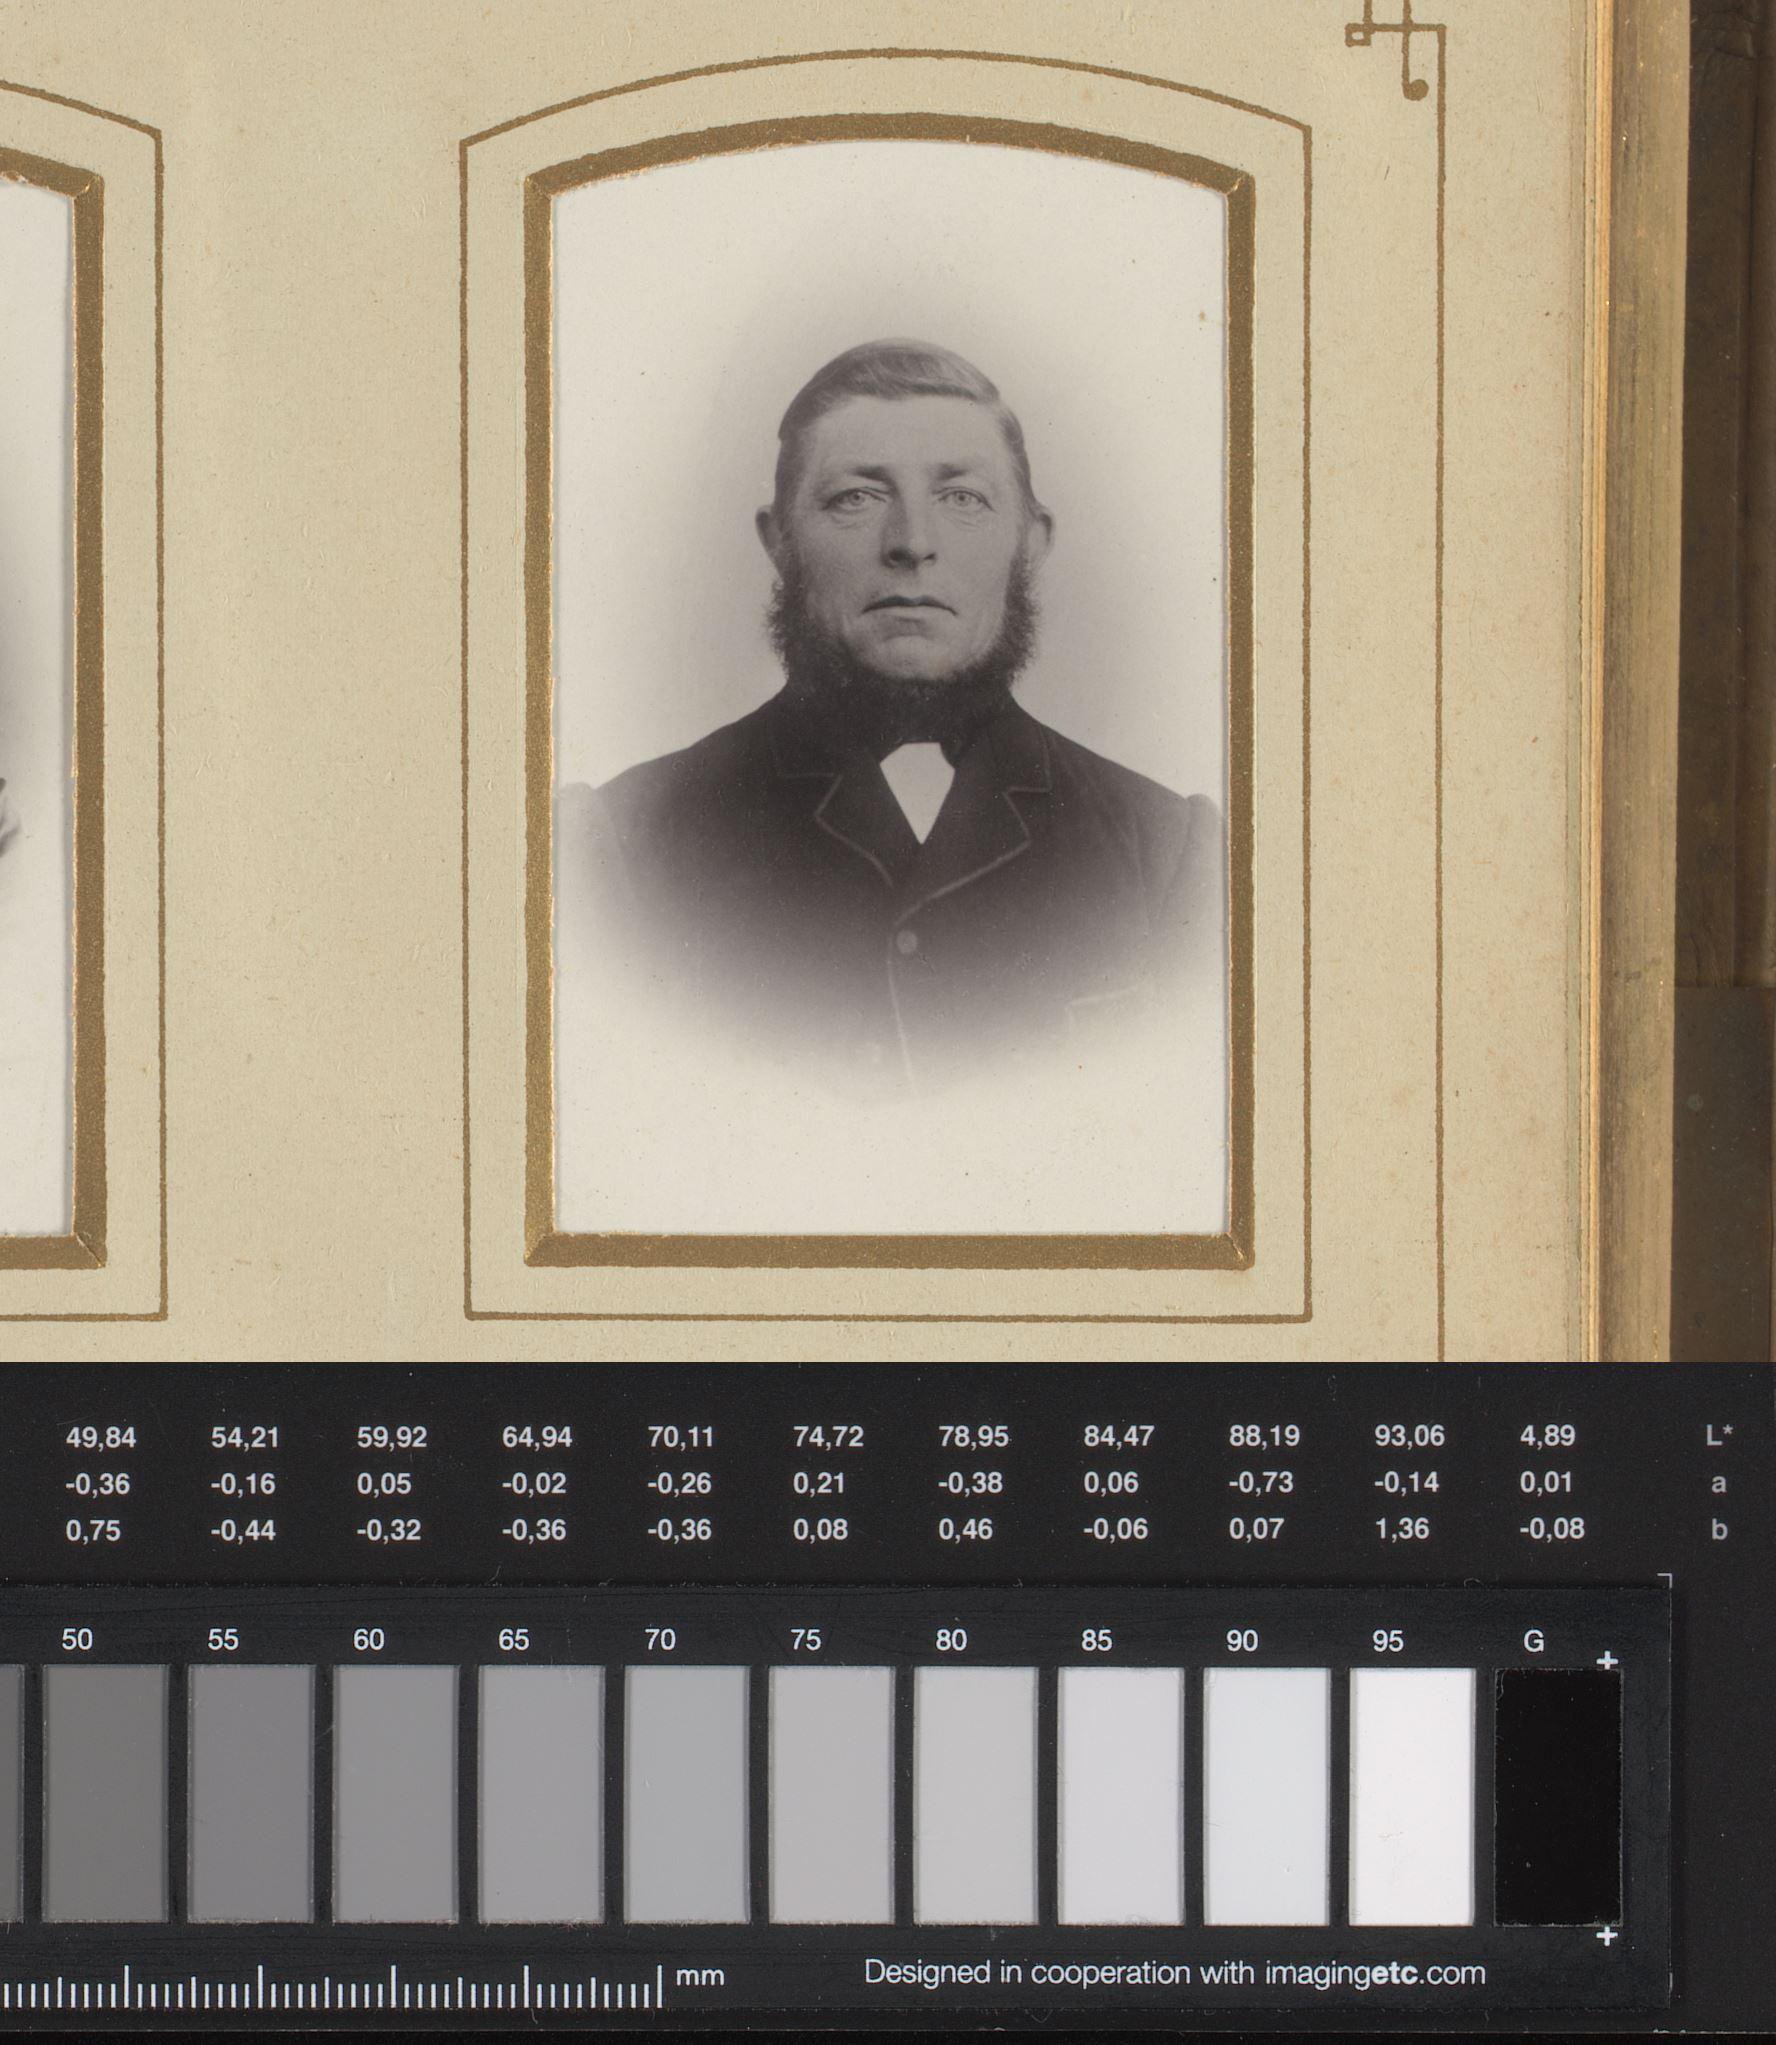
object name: carte de visite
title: Portret van een man met ringbaard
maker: cornelis bos jr.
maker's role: fotograaf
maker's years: 1869-1953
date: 1889-1920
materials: cardboard, photographic support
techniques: matte daylight collodion silver print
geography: hoorn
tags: historical persons, beard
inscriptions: inscription: ‘Corn. Bos jr./ GOUW 27/ Hoorn.’